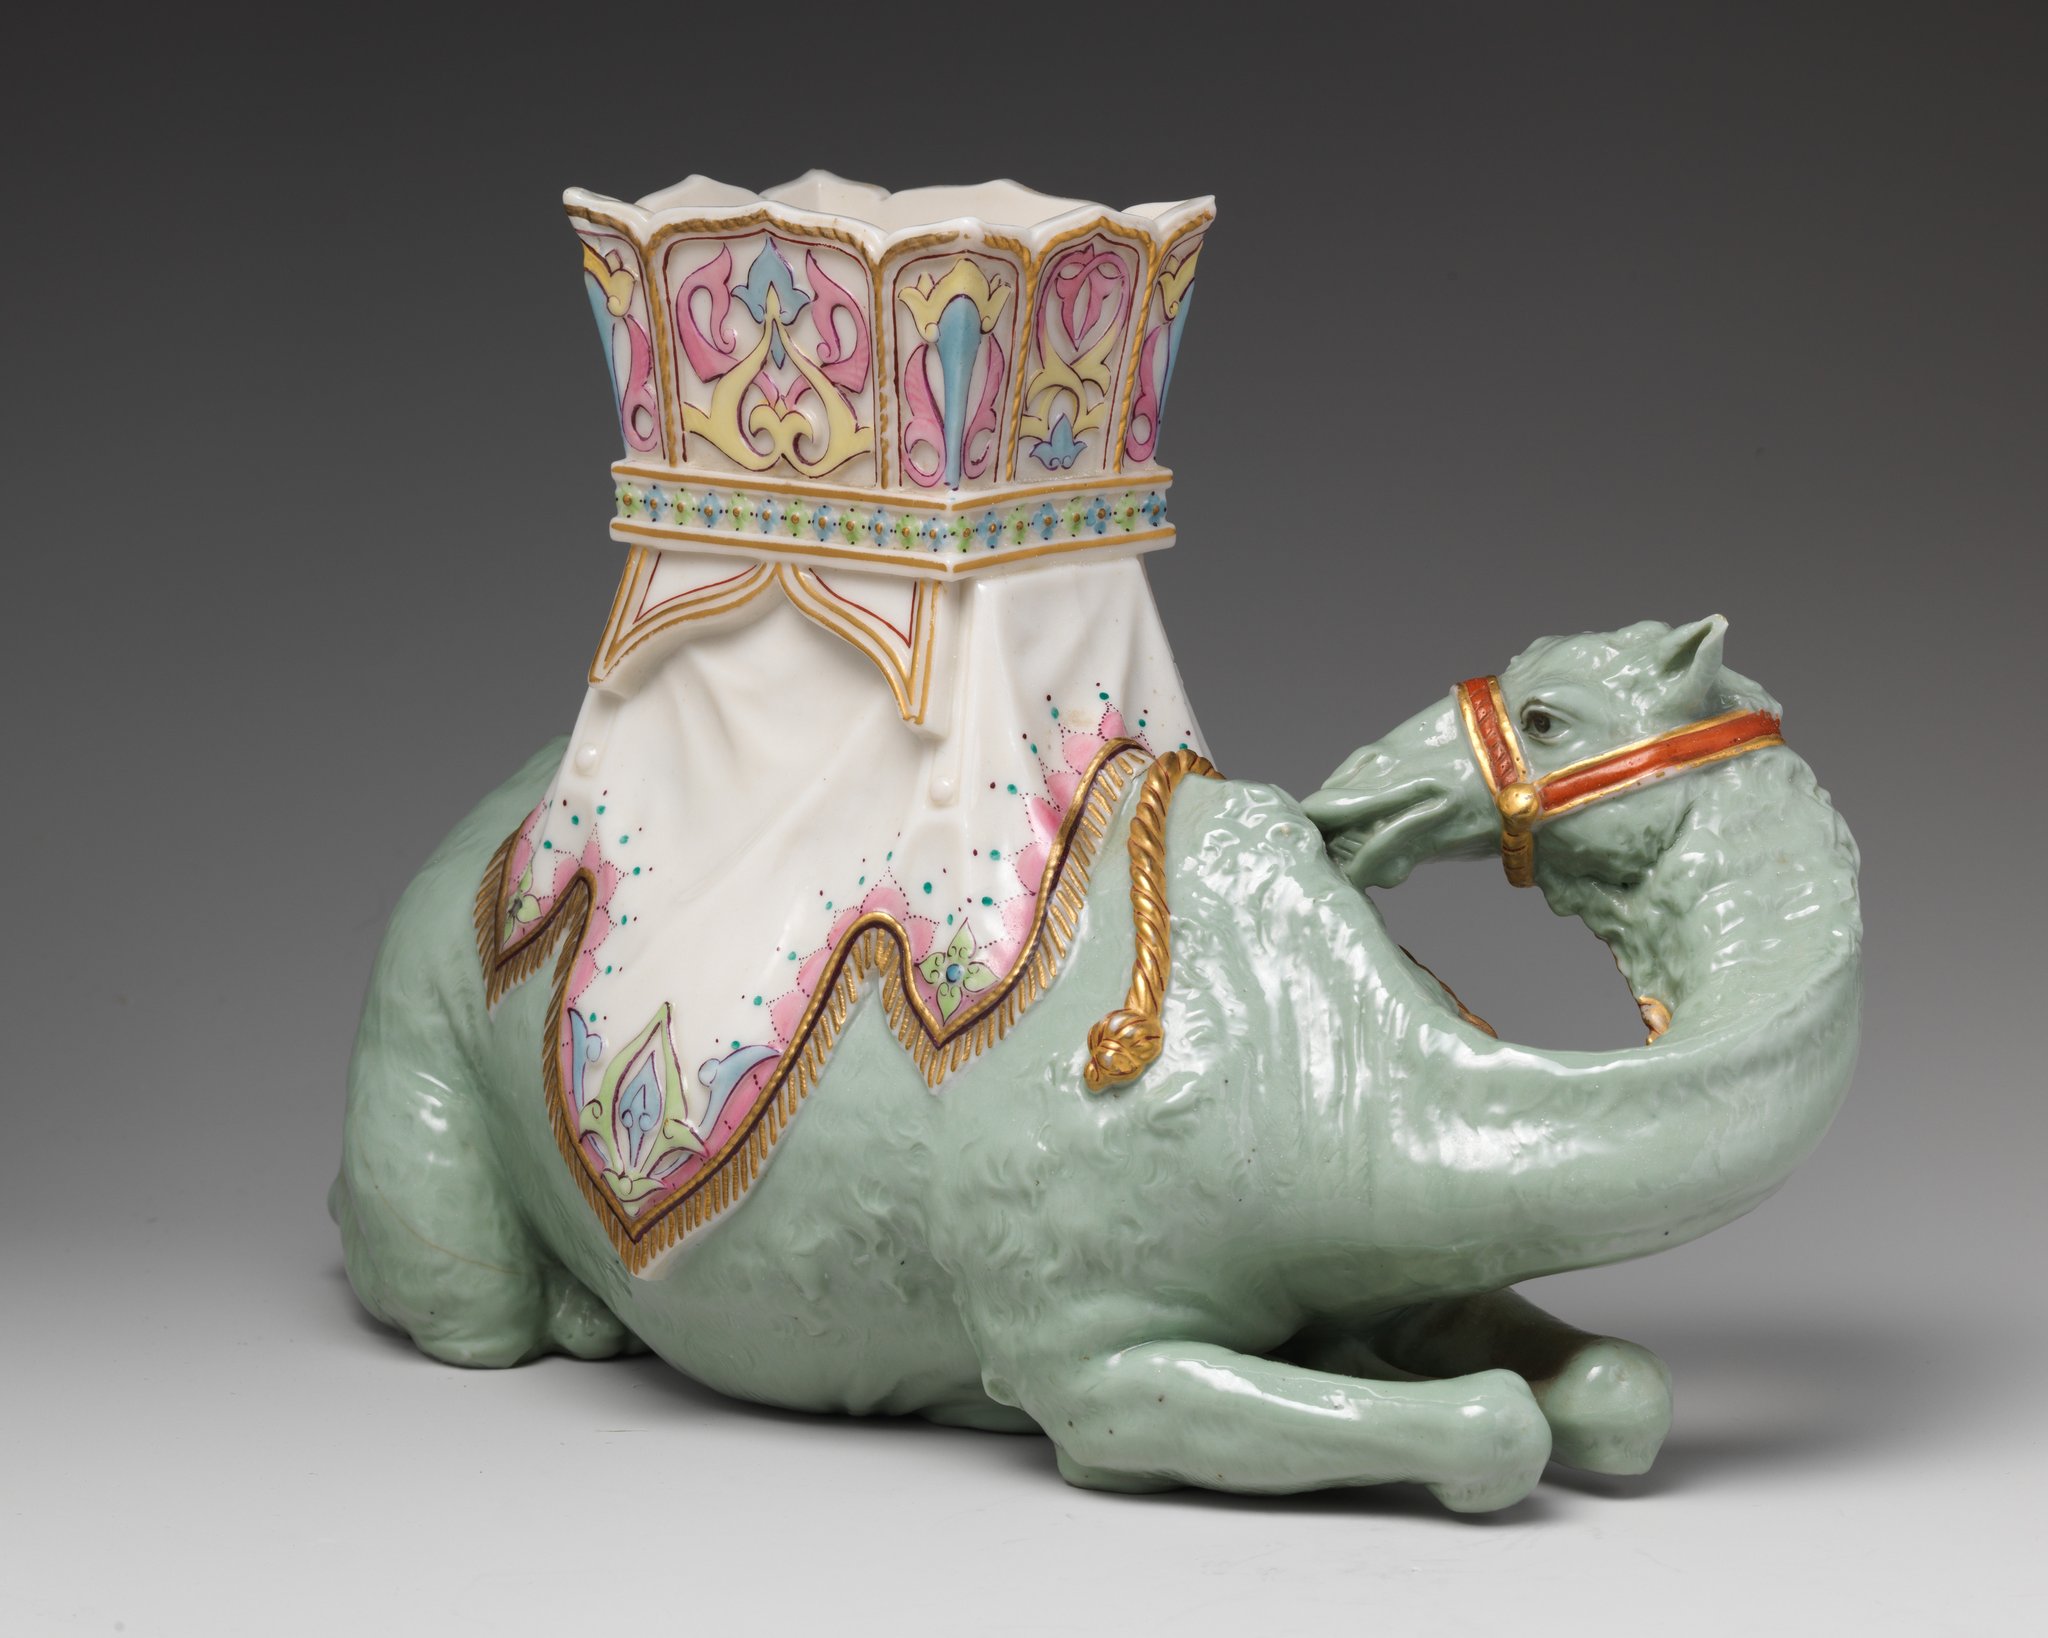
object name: vase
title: Vase in the form of a camel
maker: worcester factory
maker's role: maker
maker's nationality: british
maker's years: 1751-2008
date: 1870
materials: porcelain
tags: camels